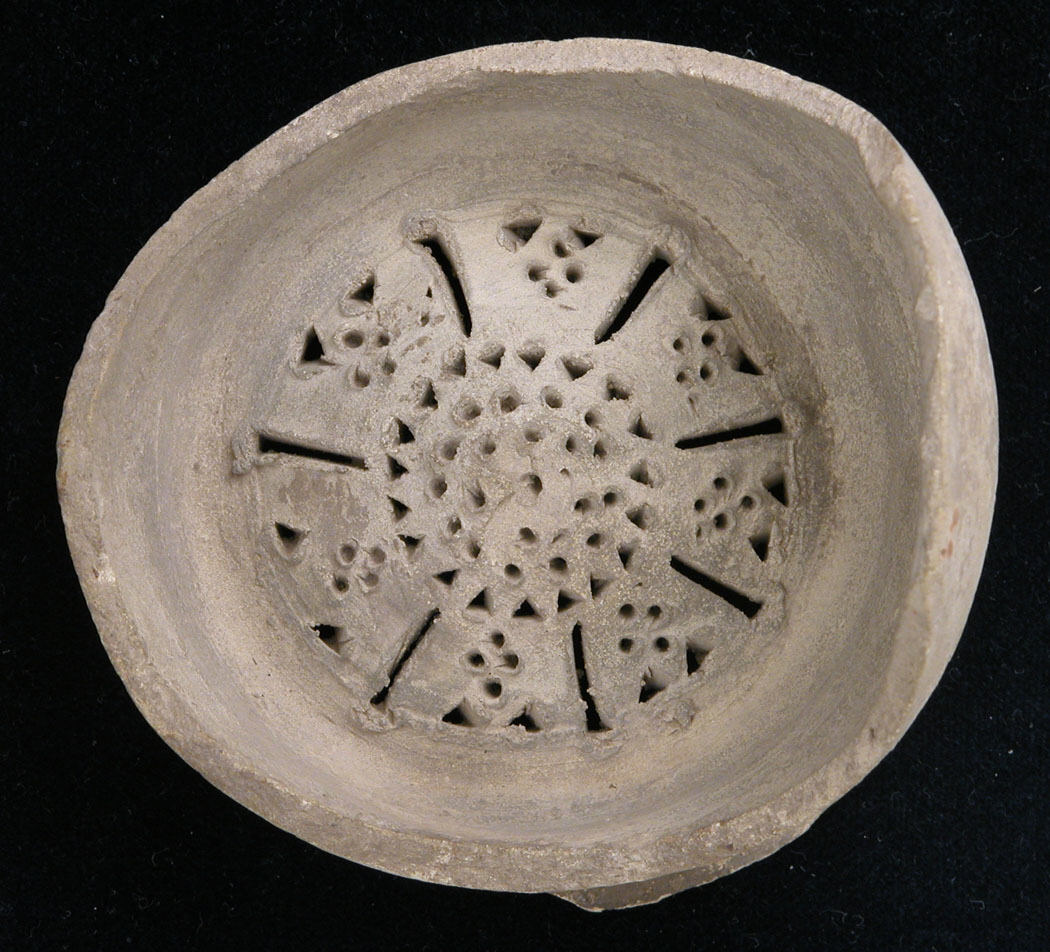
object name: water filter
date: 901-1200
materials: earthenware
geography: egypt